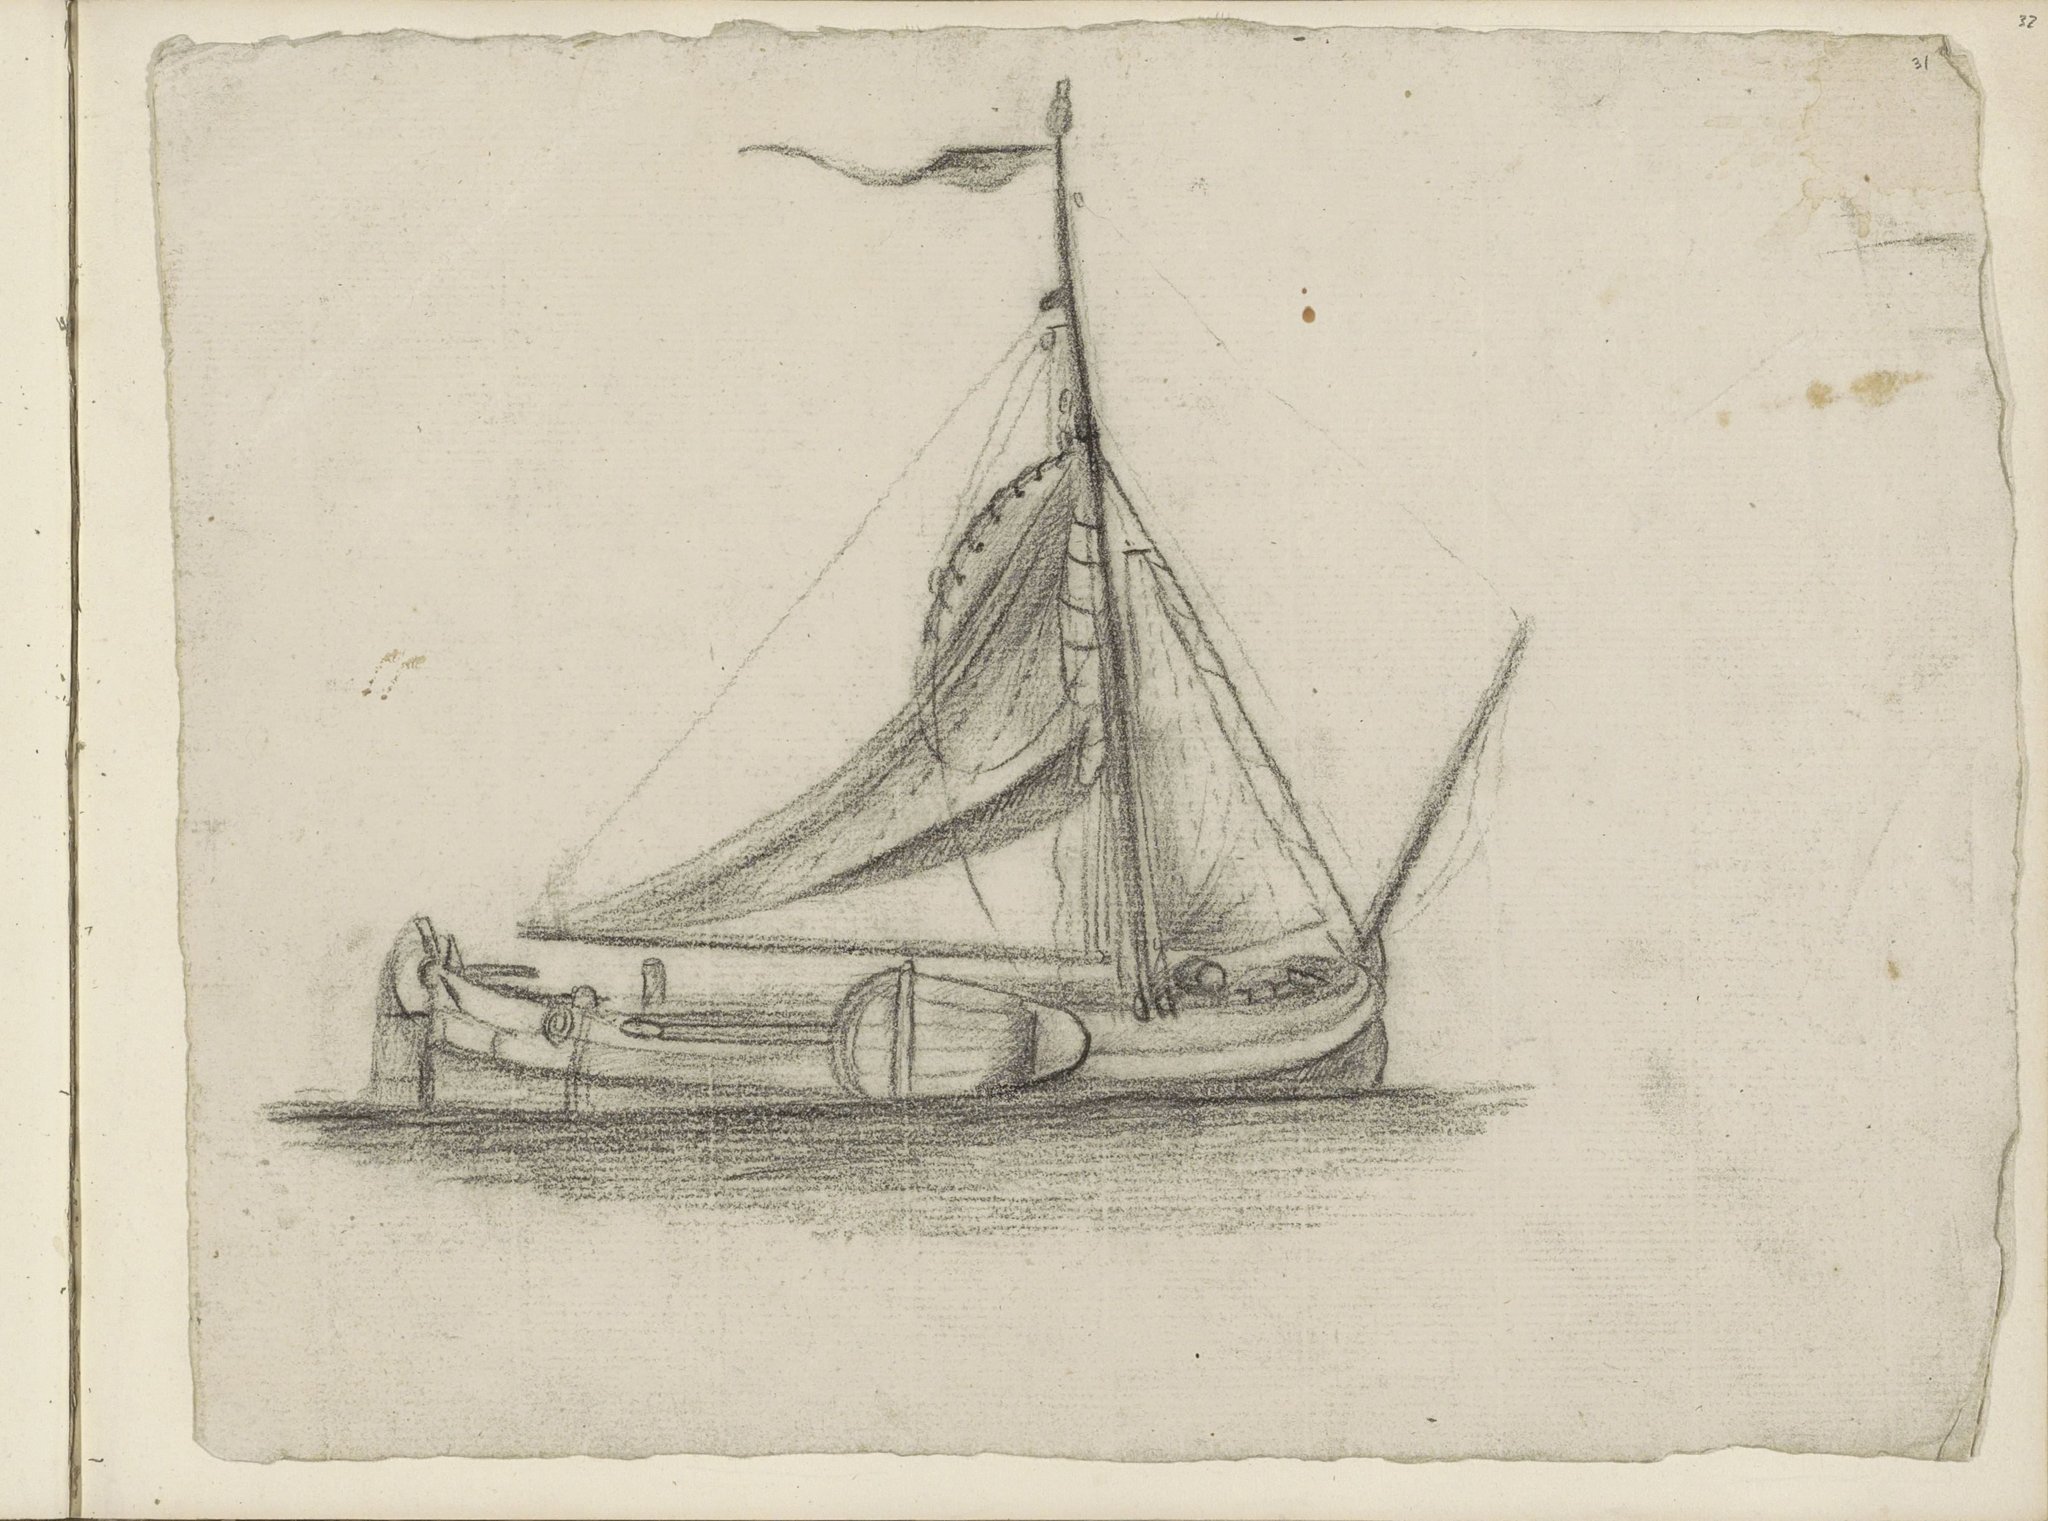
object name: sketchbook leaf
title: Vissersboot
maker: petrus johannes schotel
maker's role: draughtsman, painter, print maker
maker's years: 1808-1865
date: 1825-1875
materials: chalk, paper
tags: sailing-ship, sailing-boat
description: Blad 31 recto, los blad in een schetsboek met 44 bladen.